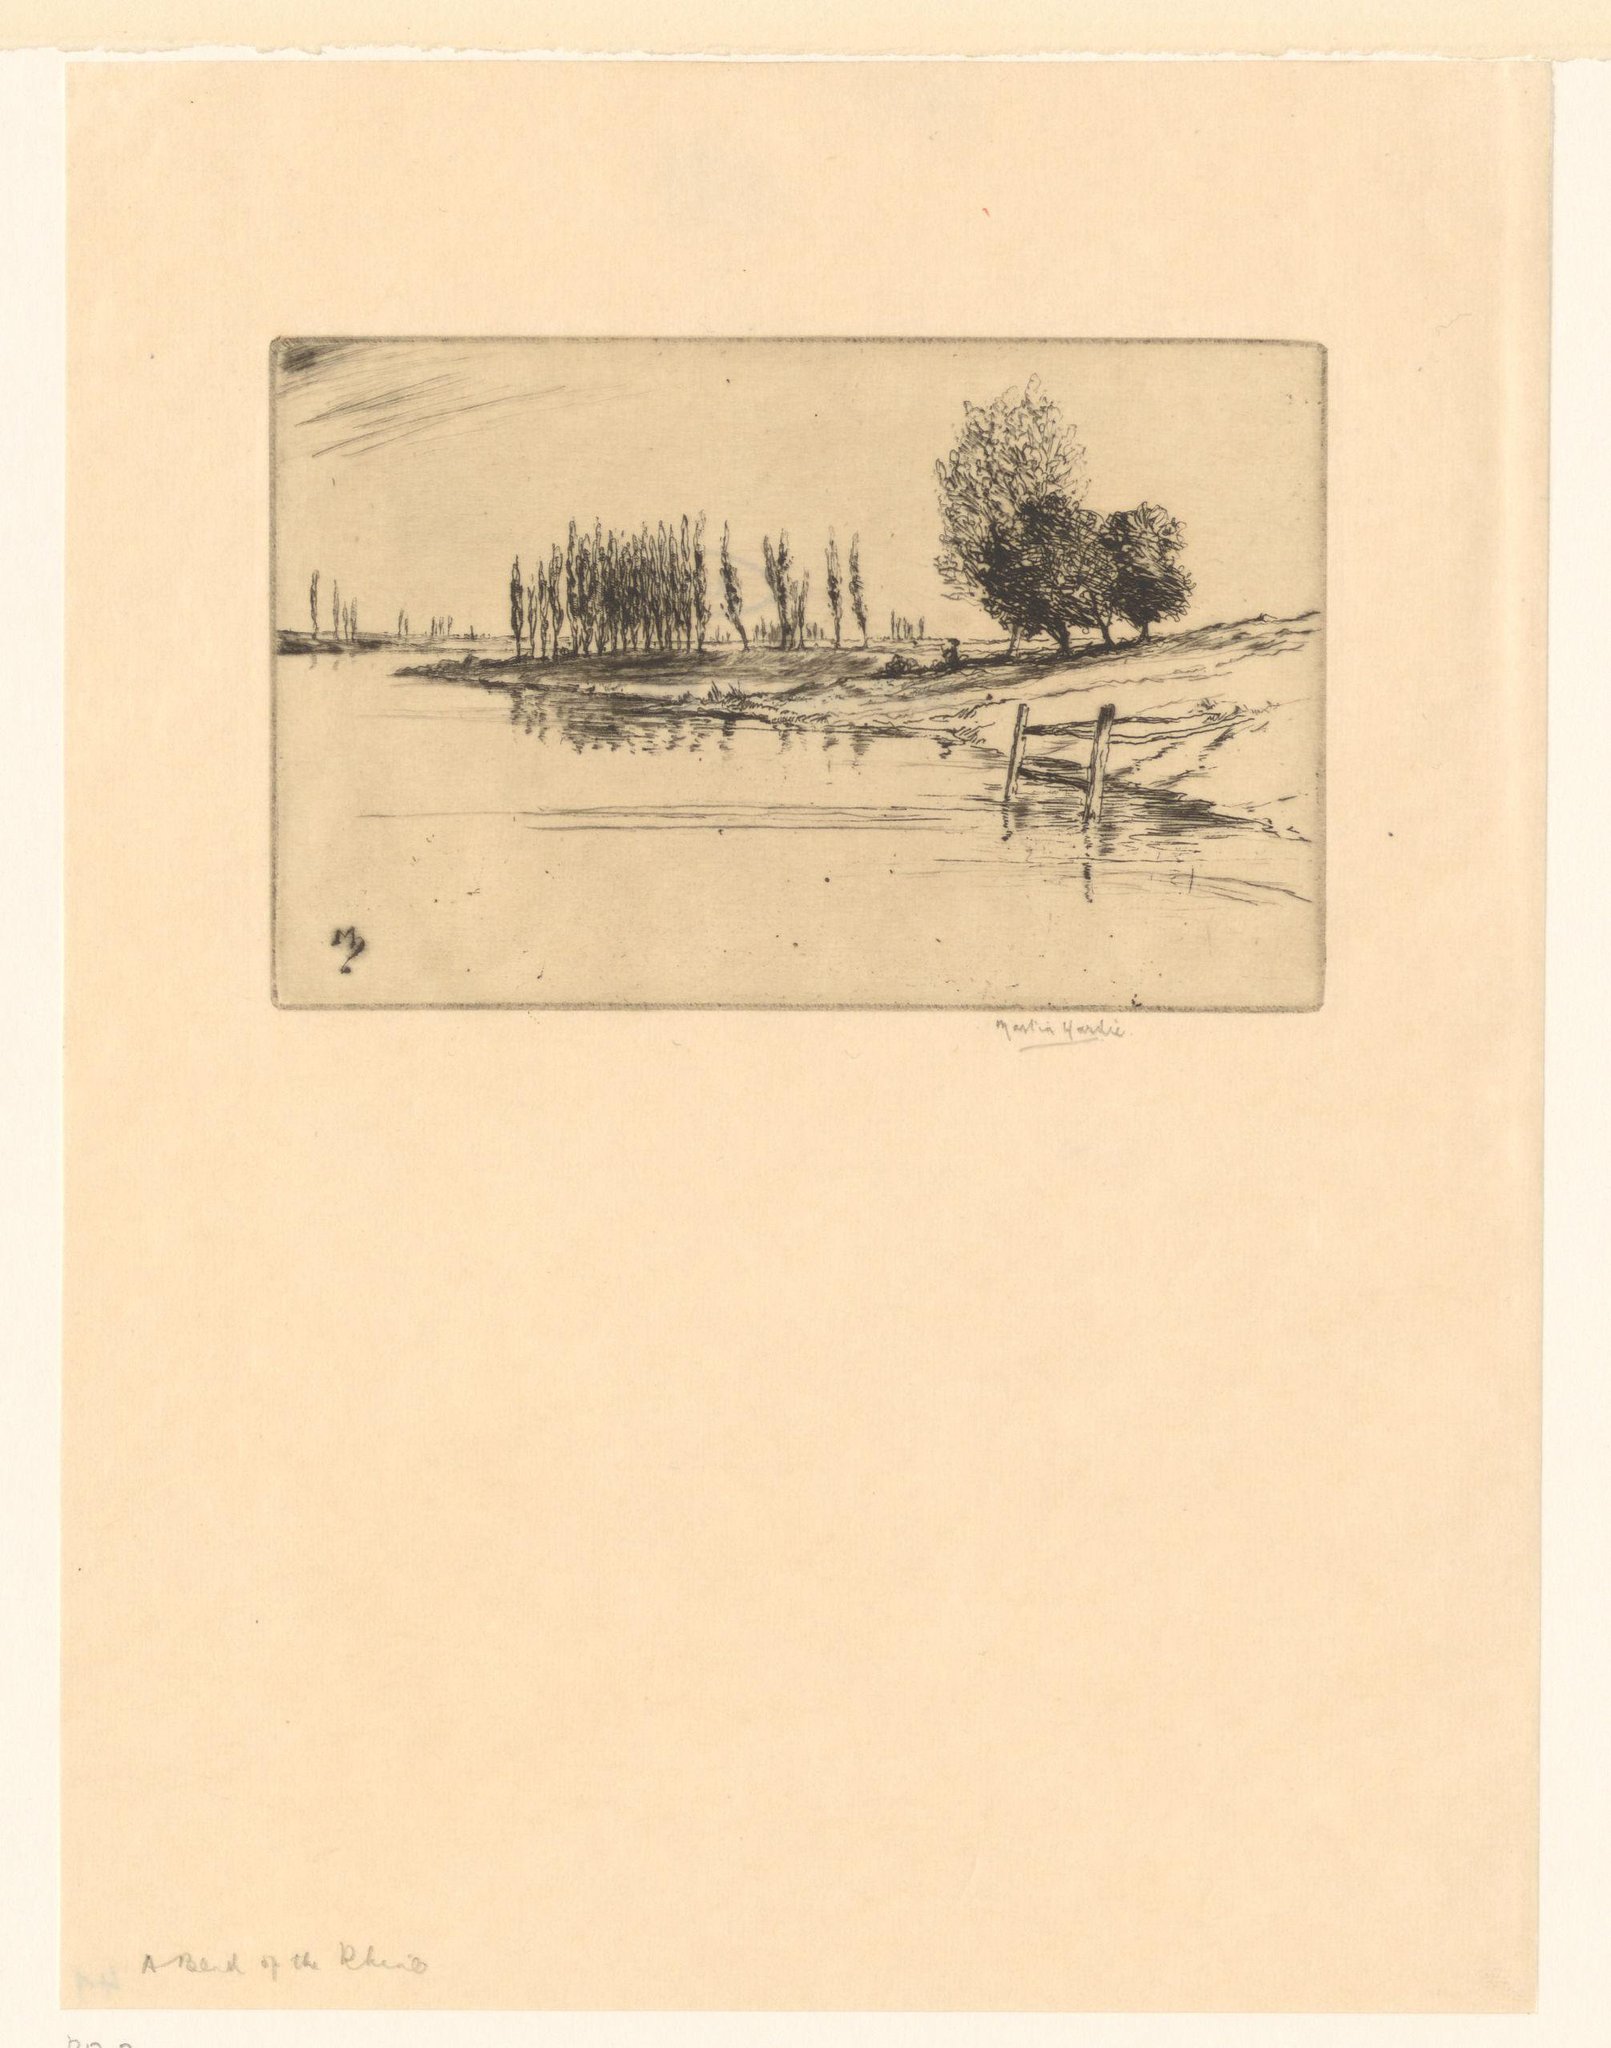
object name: print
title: Bocht in de rivier de Rijn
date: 1912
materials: paper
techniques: drypoint, etching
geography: rhineland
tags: river, cologne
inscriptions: collector's mark: Lugt 2760, collector's mark: Lugt 2228, annotation: ‘Martin Hardie’